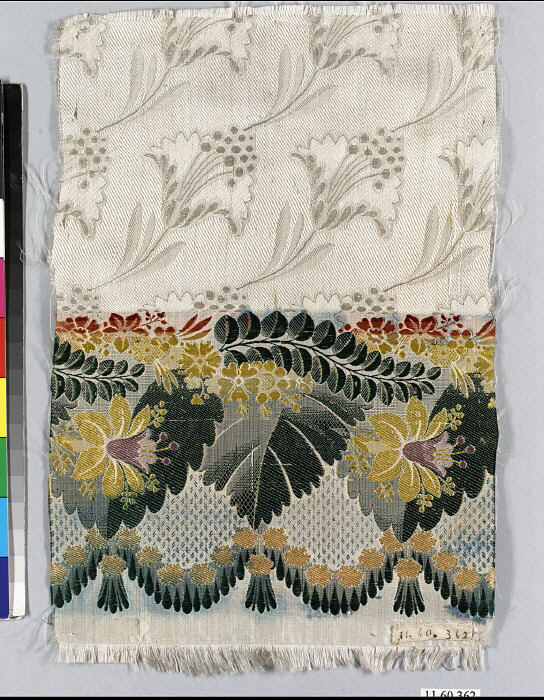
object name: fragment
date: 1801-1900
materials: silk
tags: flowers,leaves